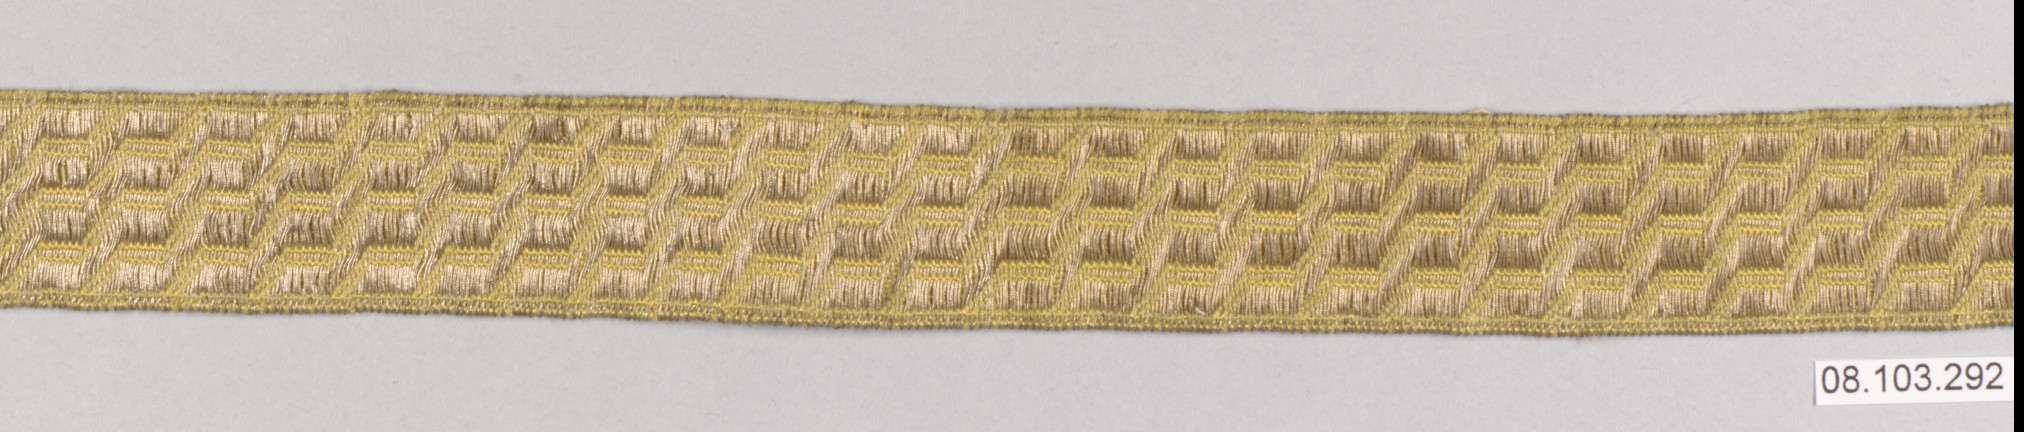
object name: galloon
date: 1601-1800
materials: metal thread, silk